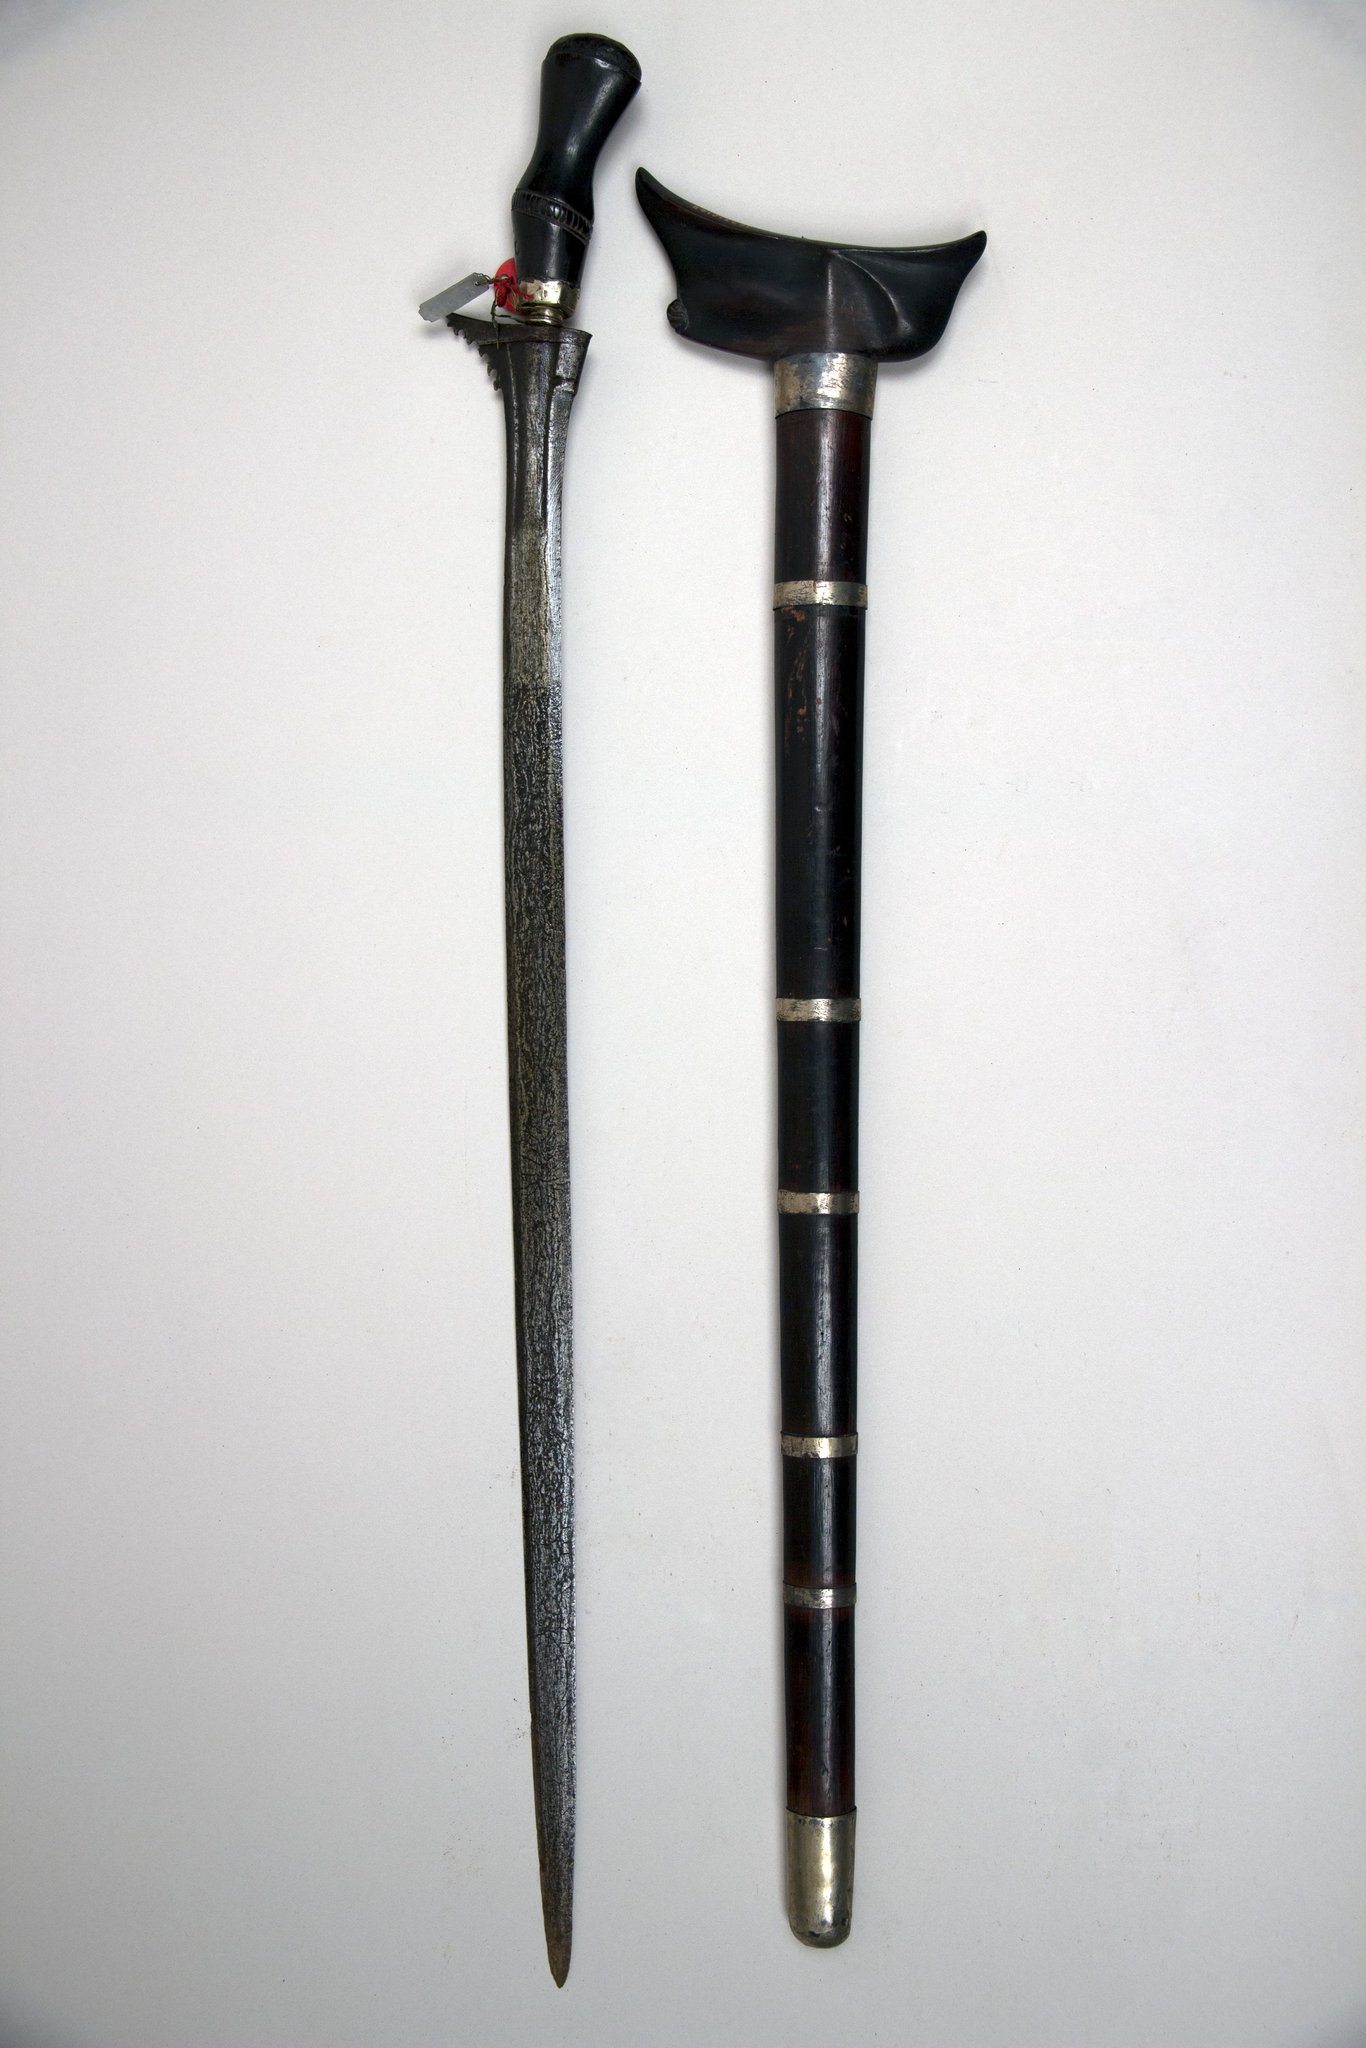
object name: executioner's kris with sheath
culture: sumatran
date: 1501-1900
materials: silver, wood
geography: indonesia